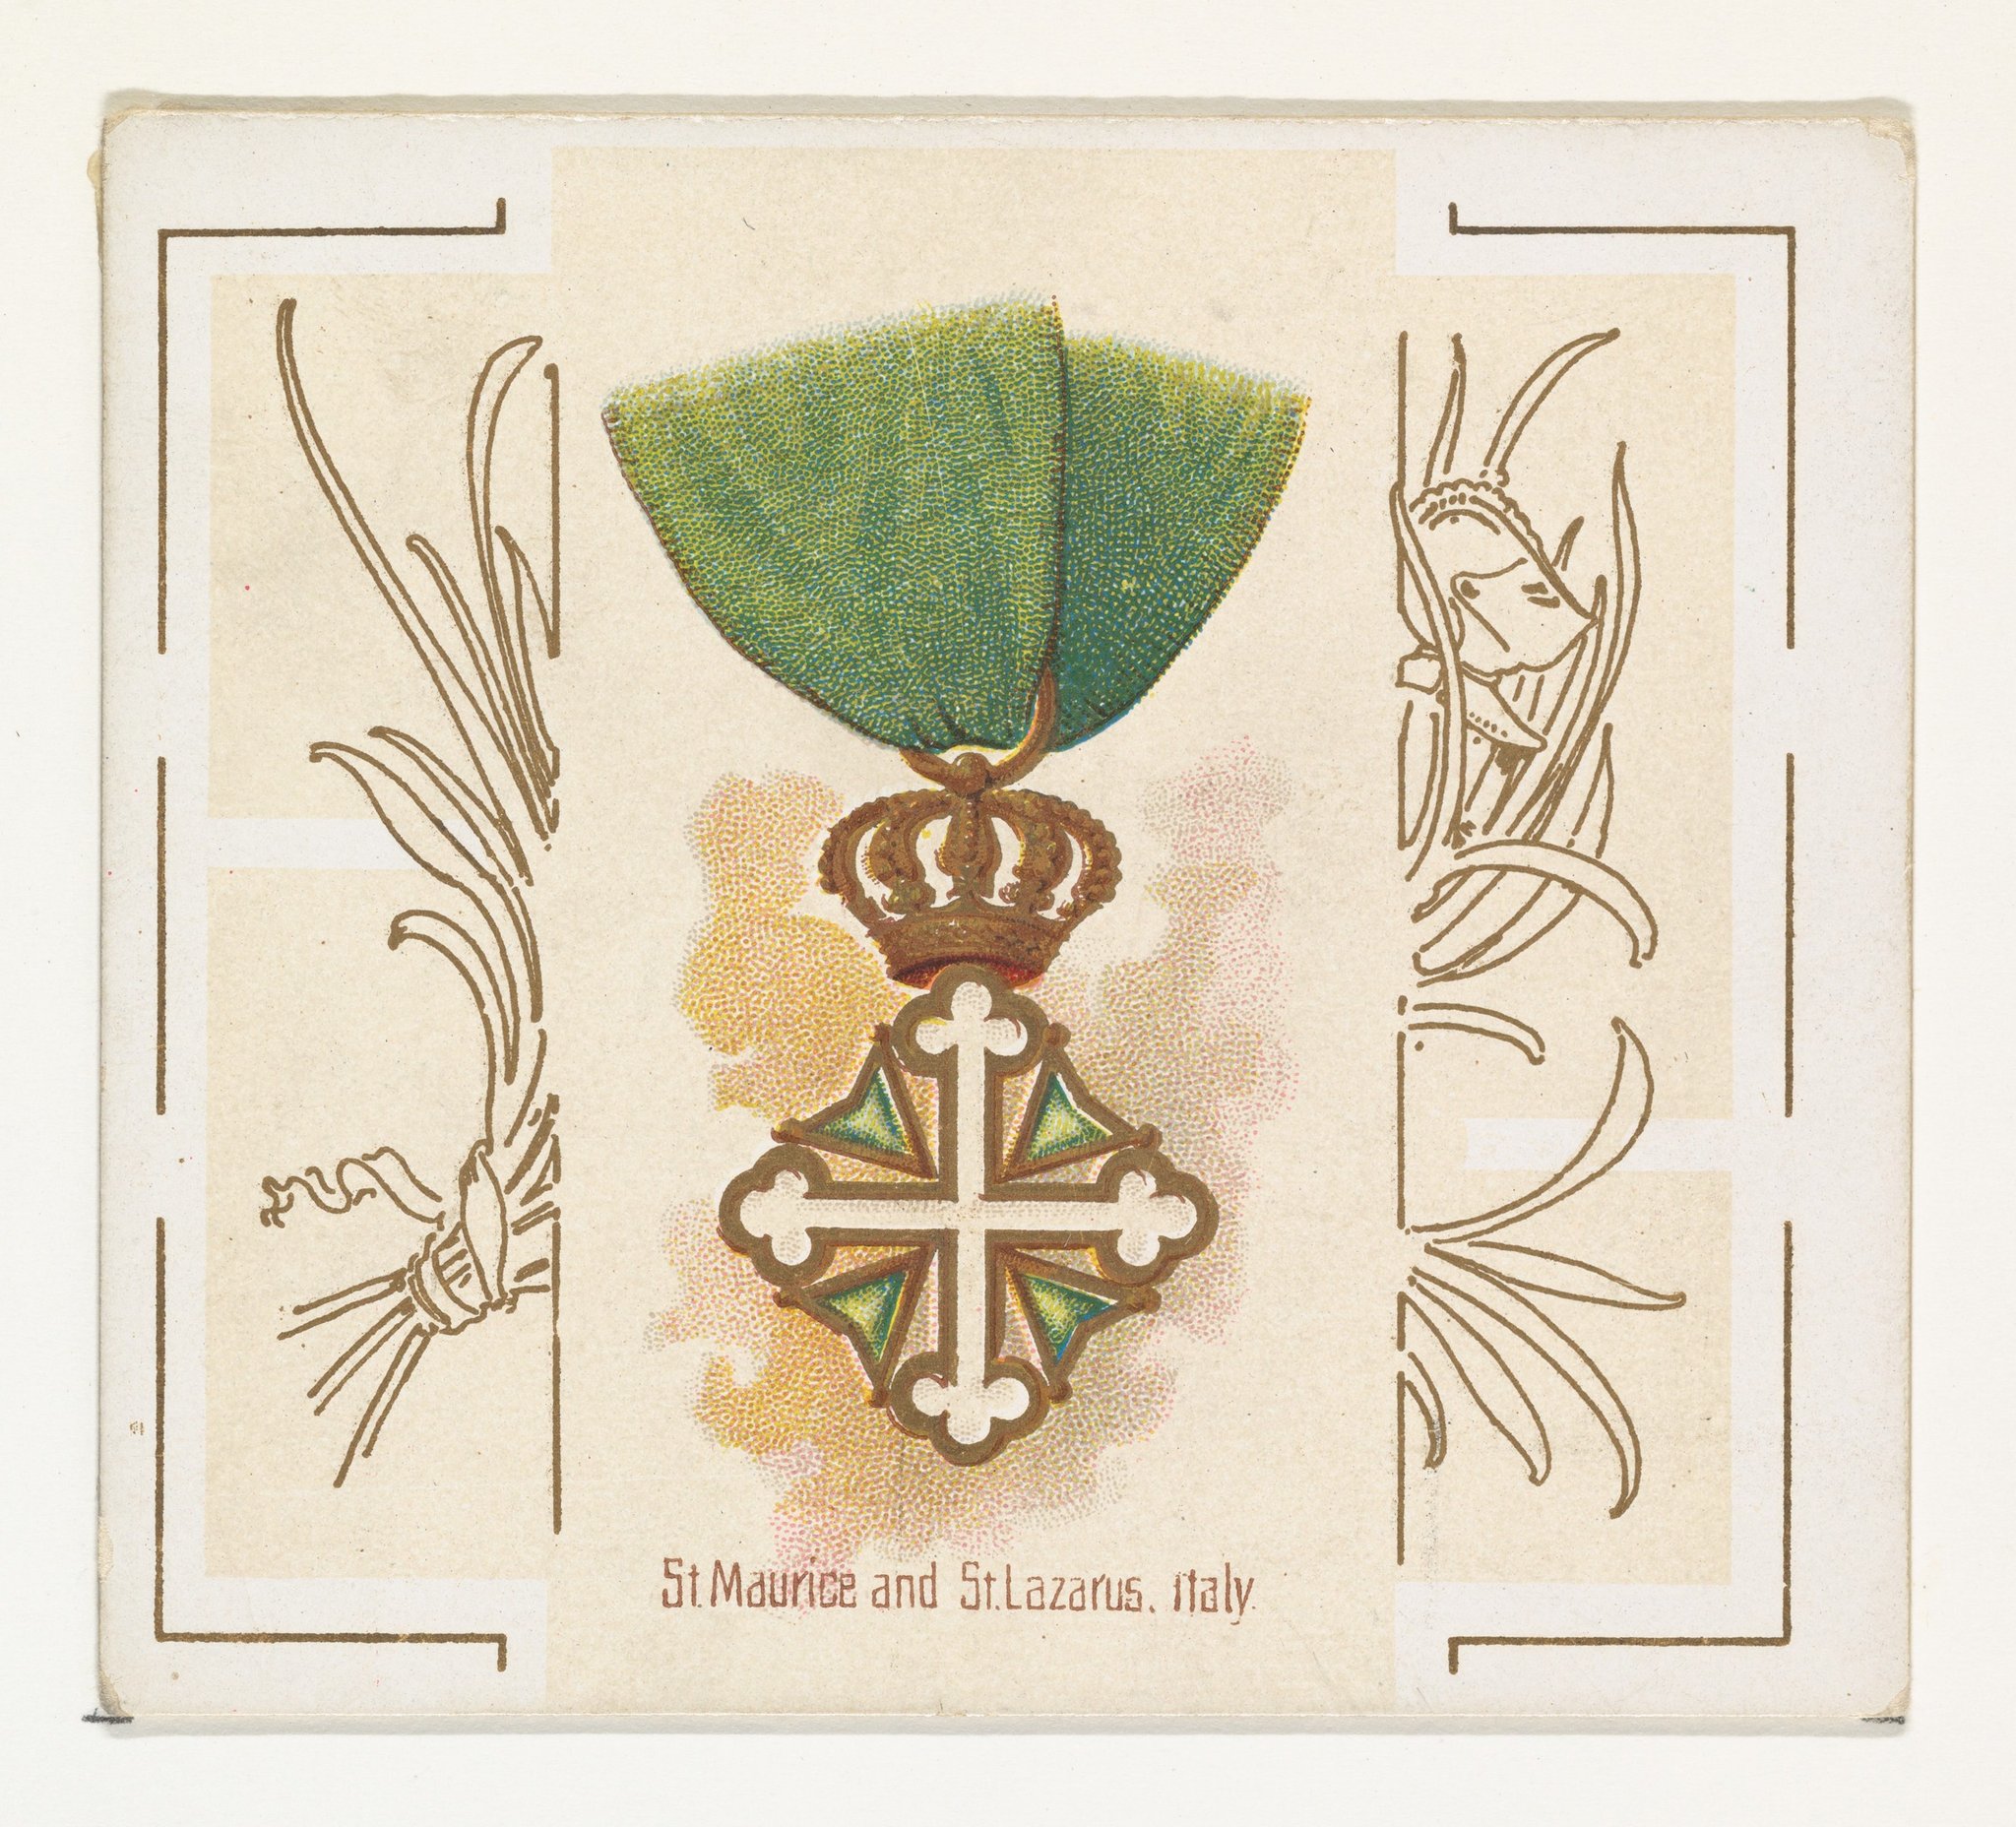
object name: print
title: Saint Maurice and Saint Lazarus, Italy, from the World's Decorations series (N44) for Allen & Ginter Cigarettes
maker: allen & ginter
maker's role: publisher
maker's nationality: american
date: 1890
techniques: color lithograph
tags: medals